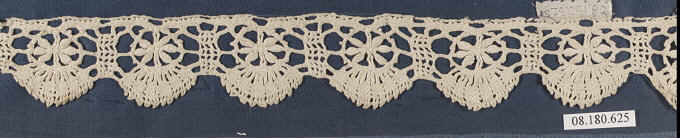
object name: piece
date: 1701-1800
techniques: lace